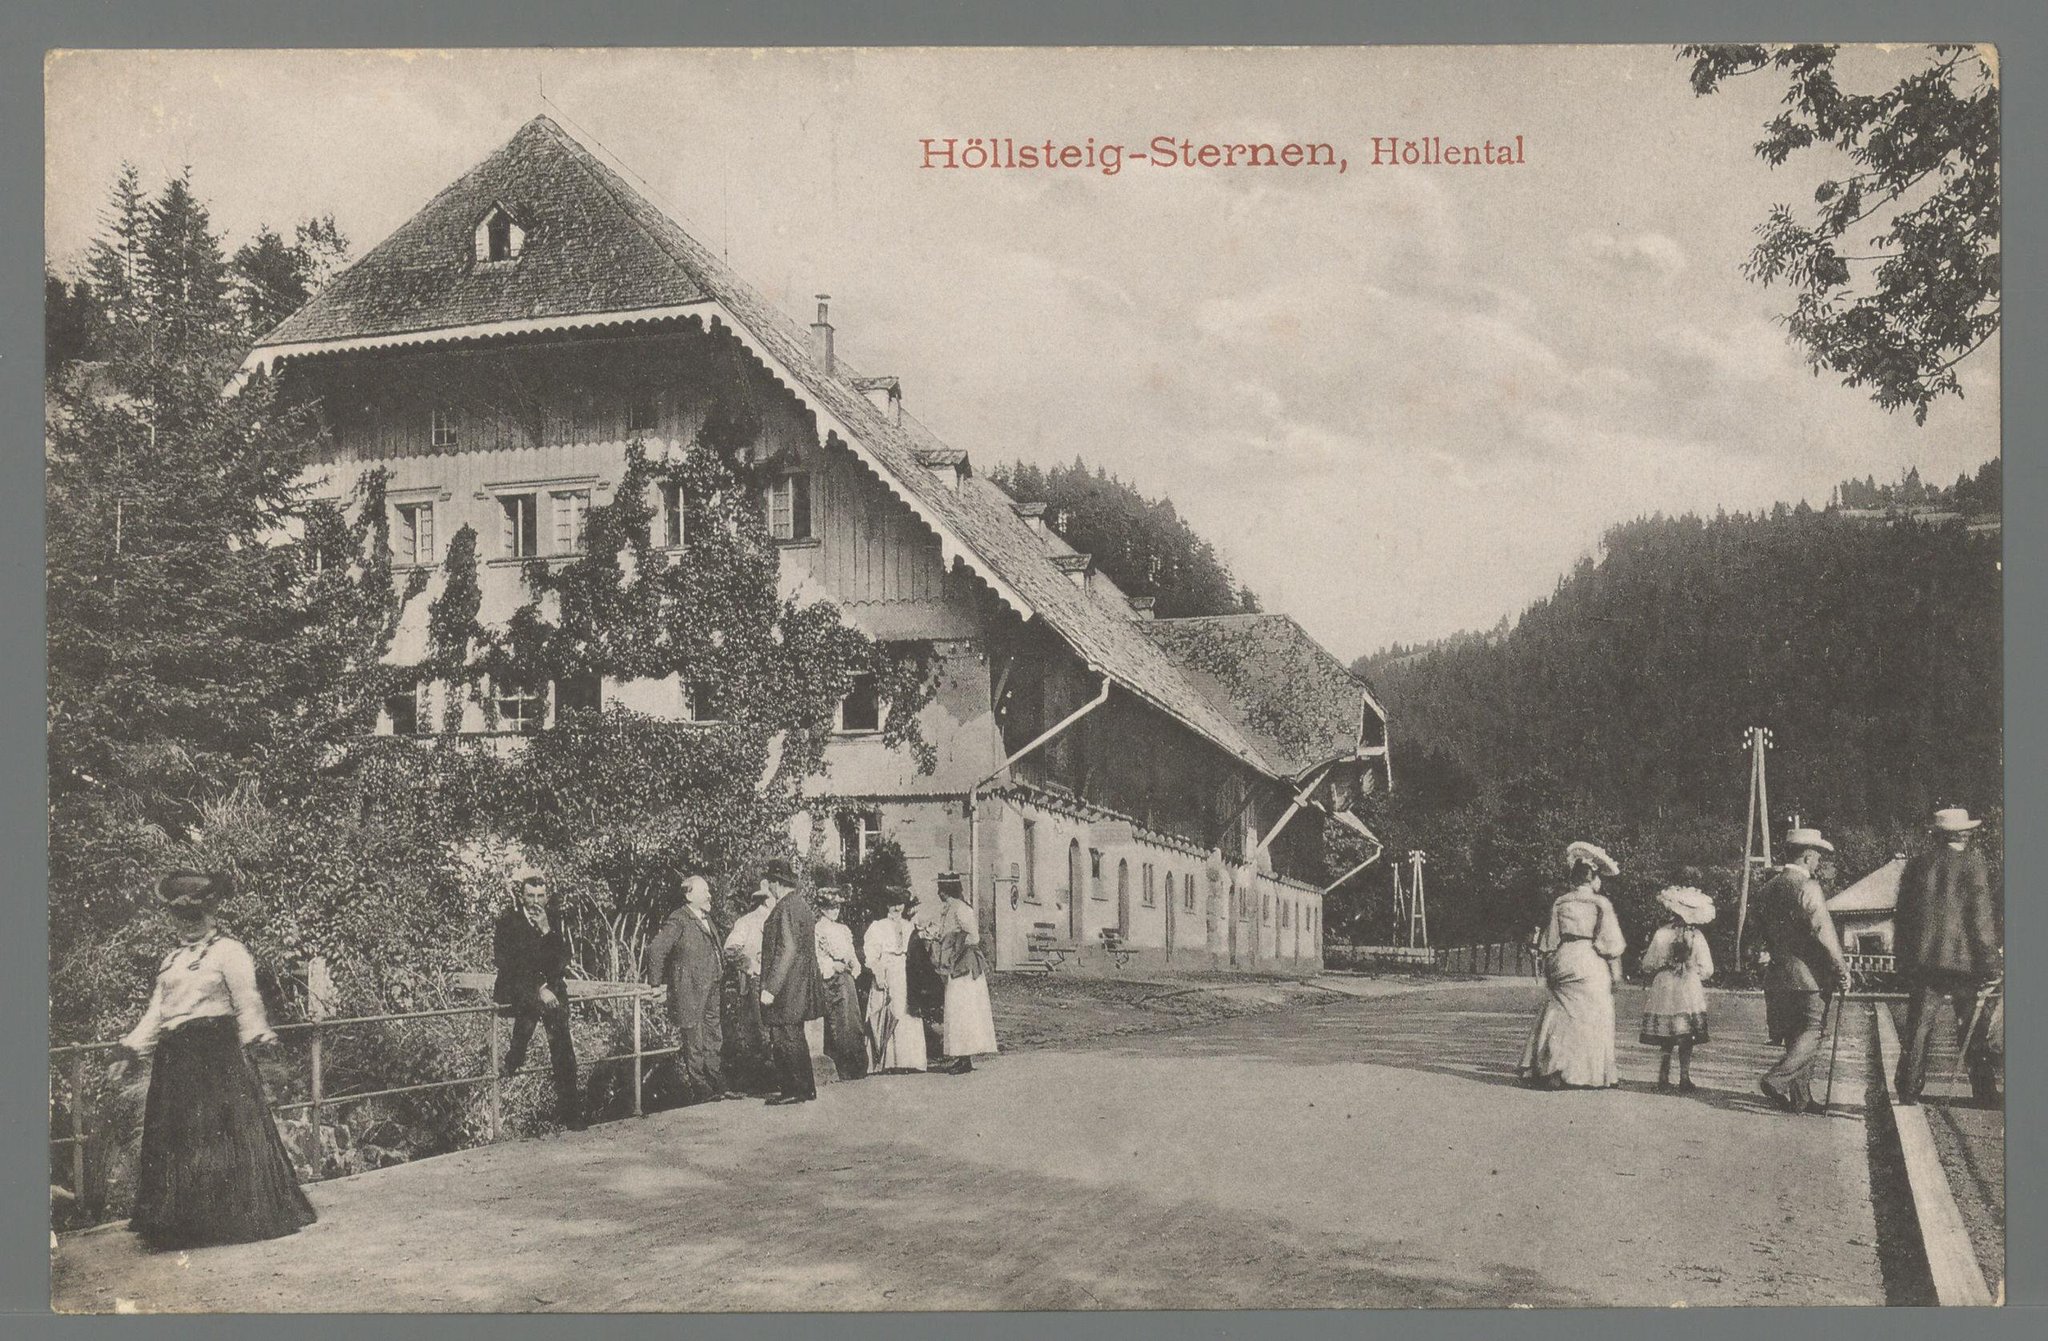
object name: ansichtkaart, prentbriefkaart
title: Höllsteig-Sternen, Höllental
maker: Anonymous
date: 1906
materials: cardboard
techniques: photograph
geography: tübingen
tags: hotel, hostelry, inn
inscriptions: date